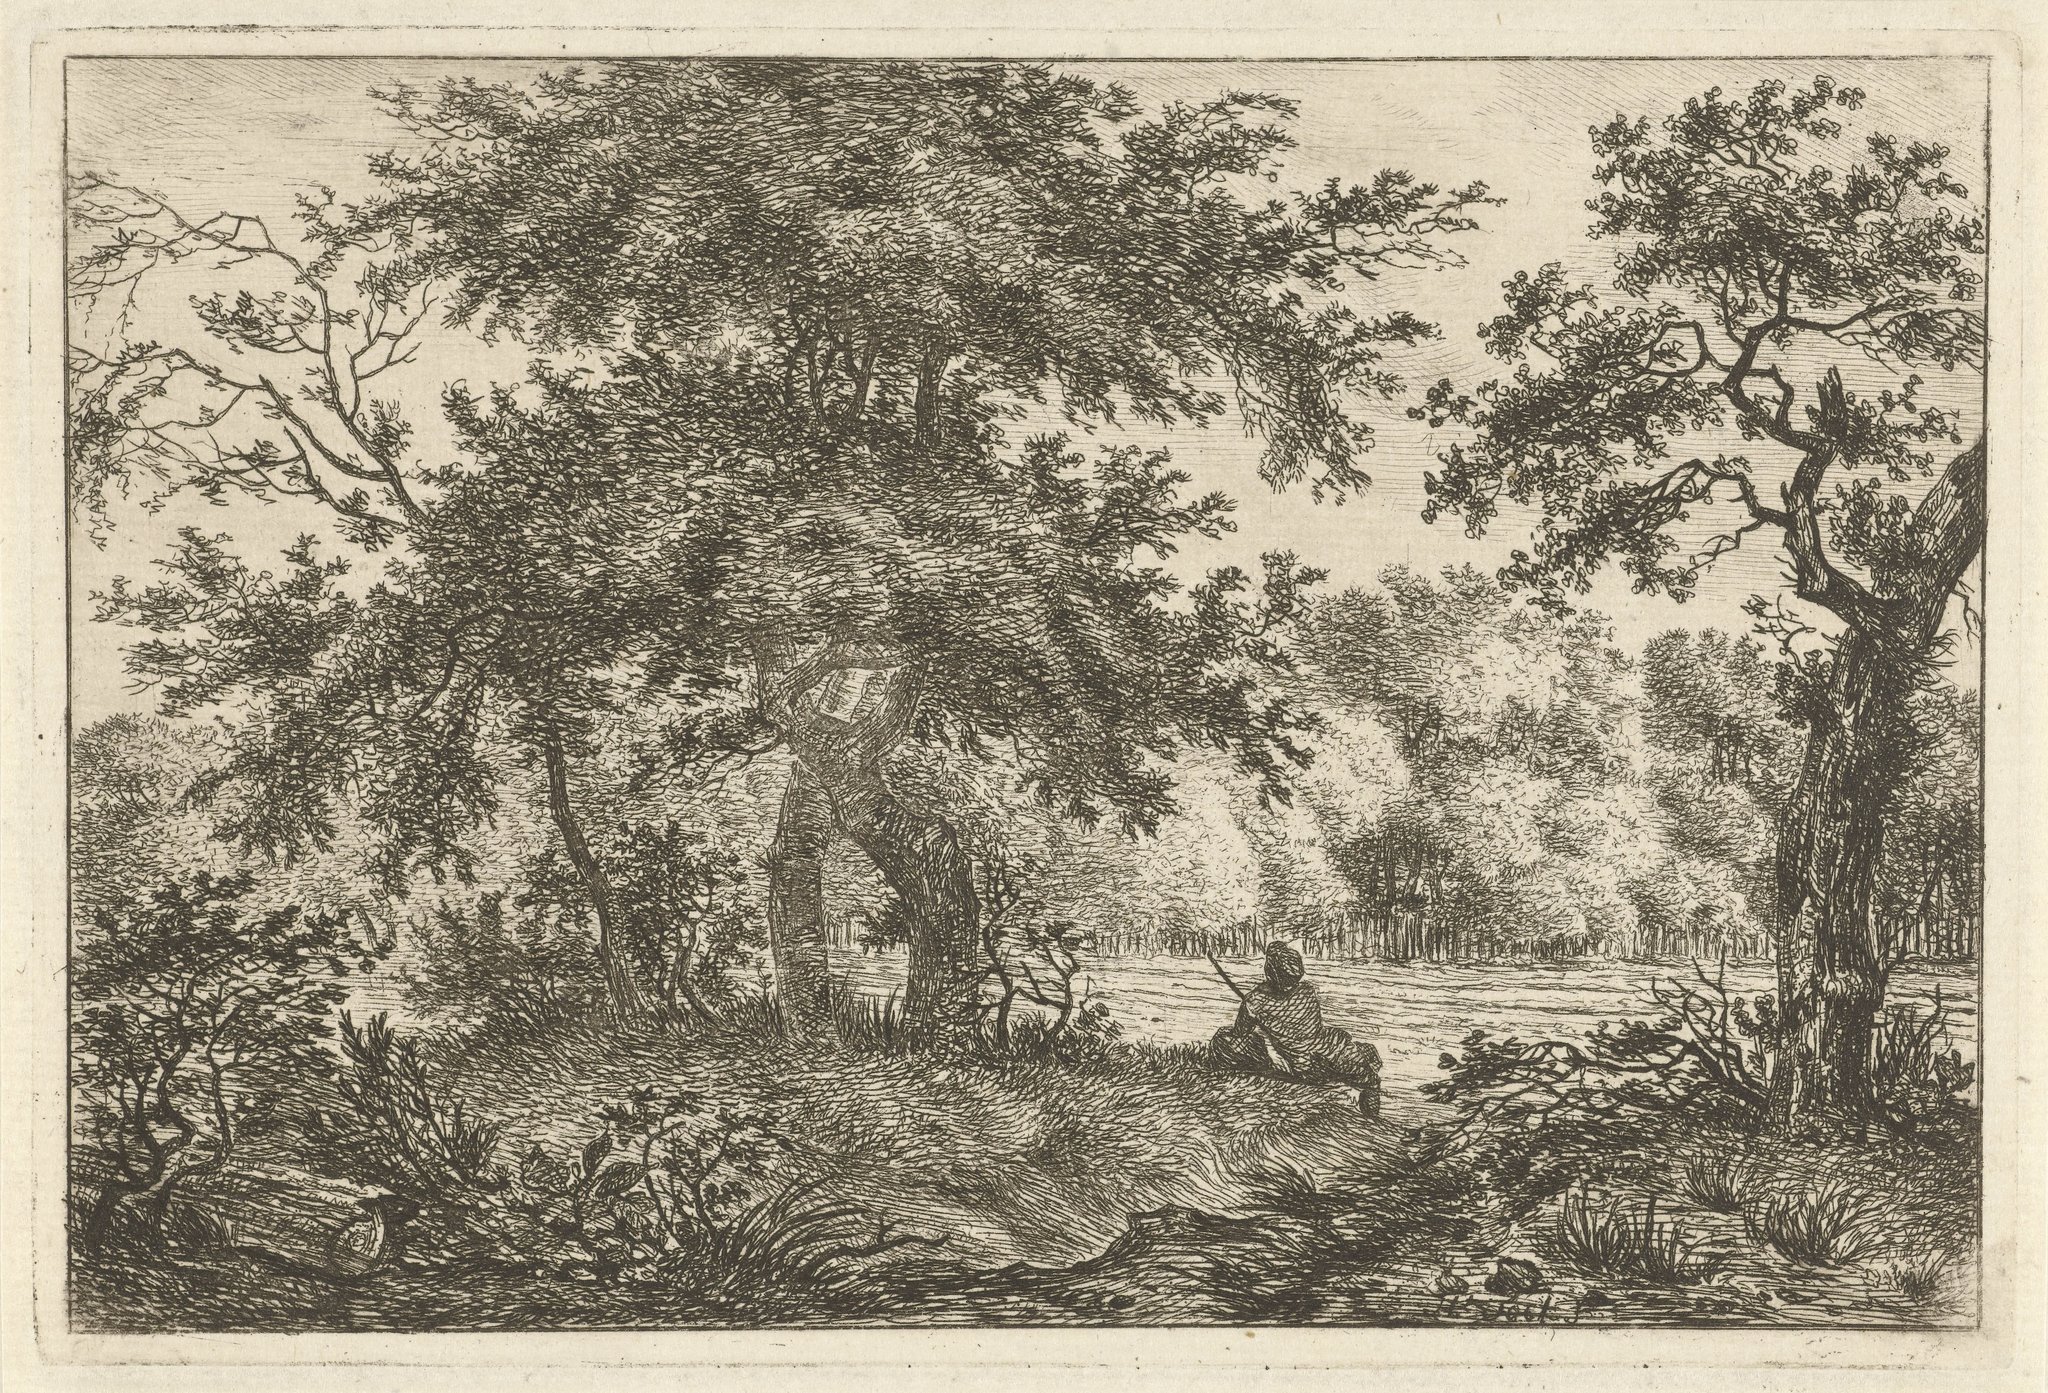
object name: print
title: Rustende man in bos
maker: hermanus fock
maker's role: conservator, draughtsman, painter, print maker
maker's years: 1766-1822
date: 1781-1822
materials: paper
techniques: etching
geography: amsterdam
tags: forest, wood (+ landscape with figures, staffage), resting - bb - out of doors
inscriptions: collector's mark: Lugt 2228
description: Een man zit in het gras onder een boom op de grens van een bos en een weide.